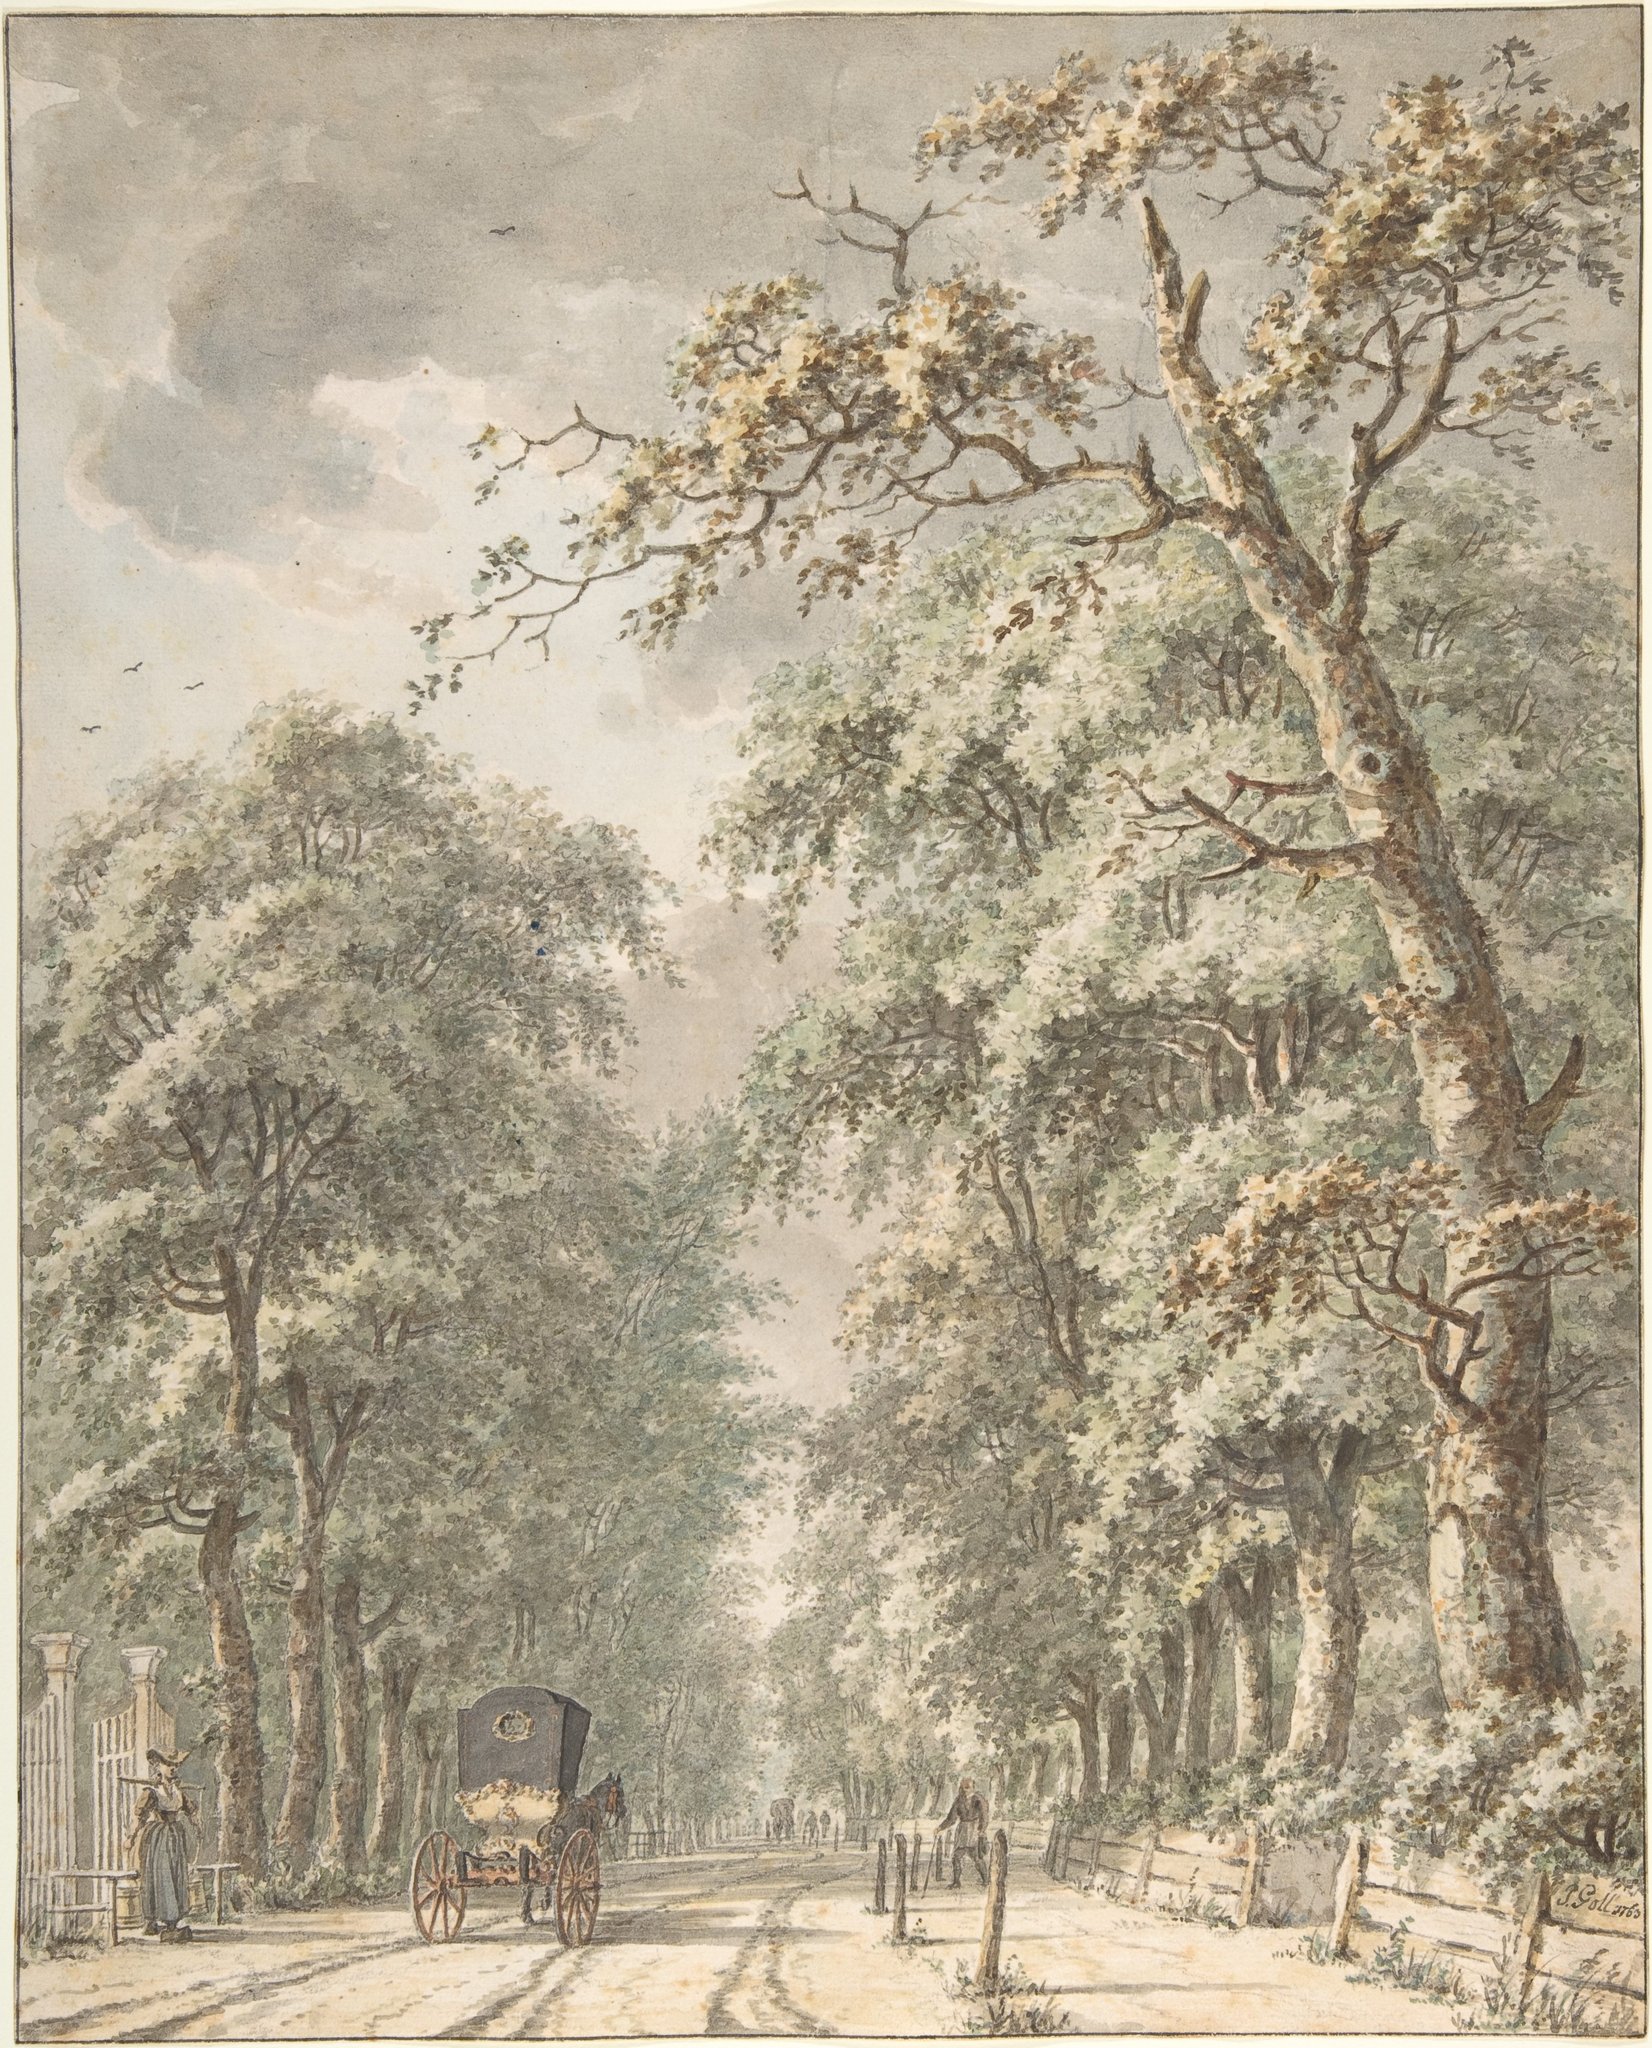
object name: drawing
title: The Amstelveen Road from Amsterdam towards Amstelveen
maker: johann edler goll van franckenstein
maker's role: artist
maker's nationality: dutch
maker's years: 1722-1785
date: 1734-1800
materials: chalk, ink, watercolor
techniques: pen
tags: roads,horses,trees,carriages